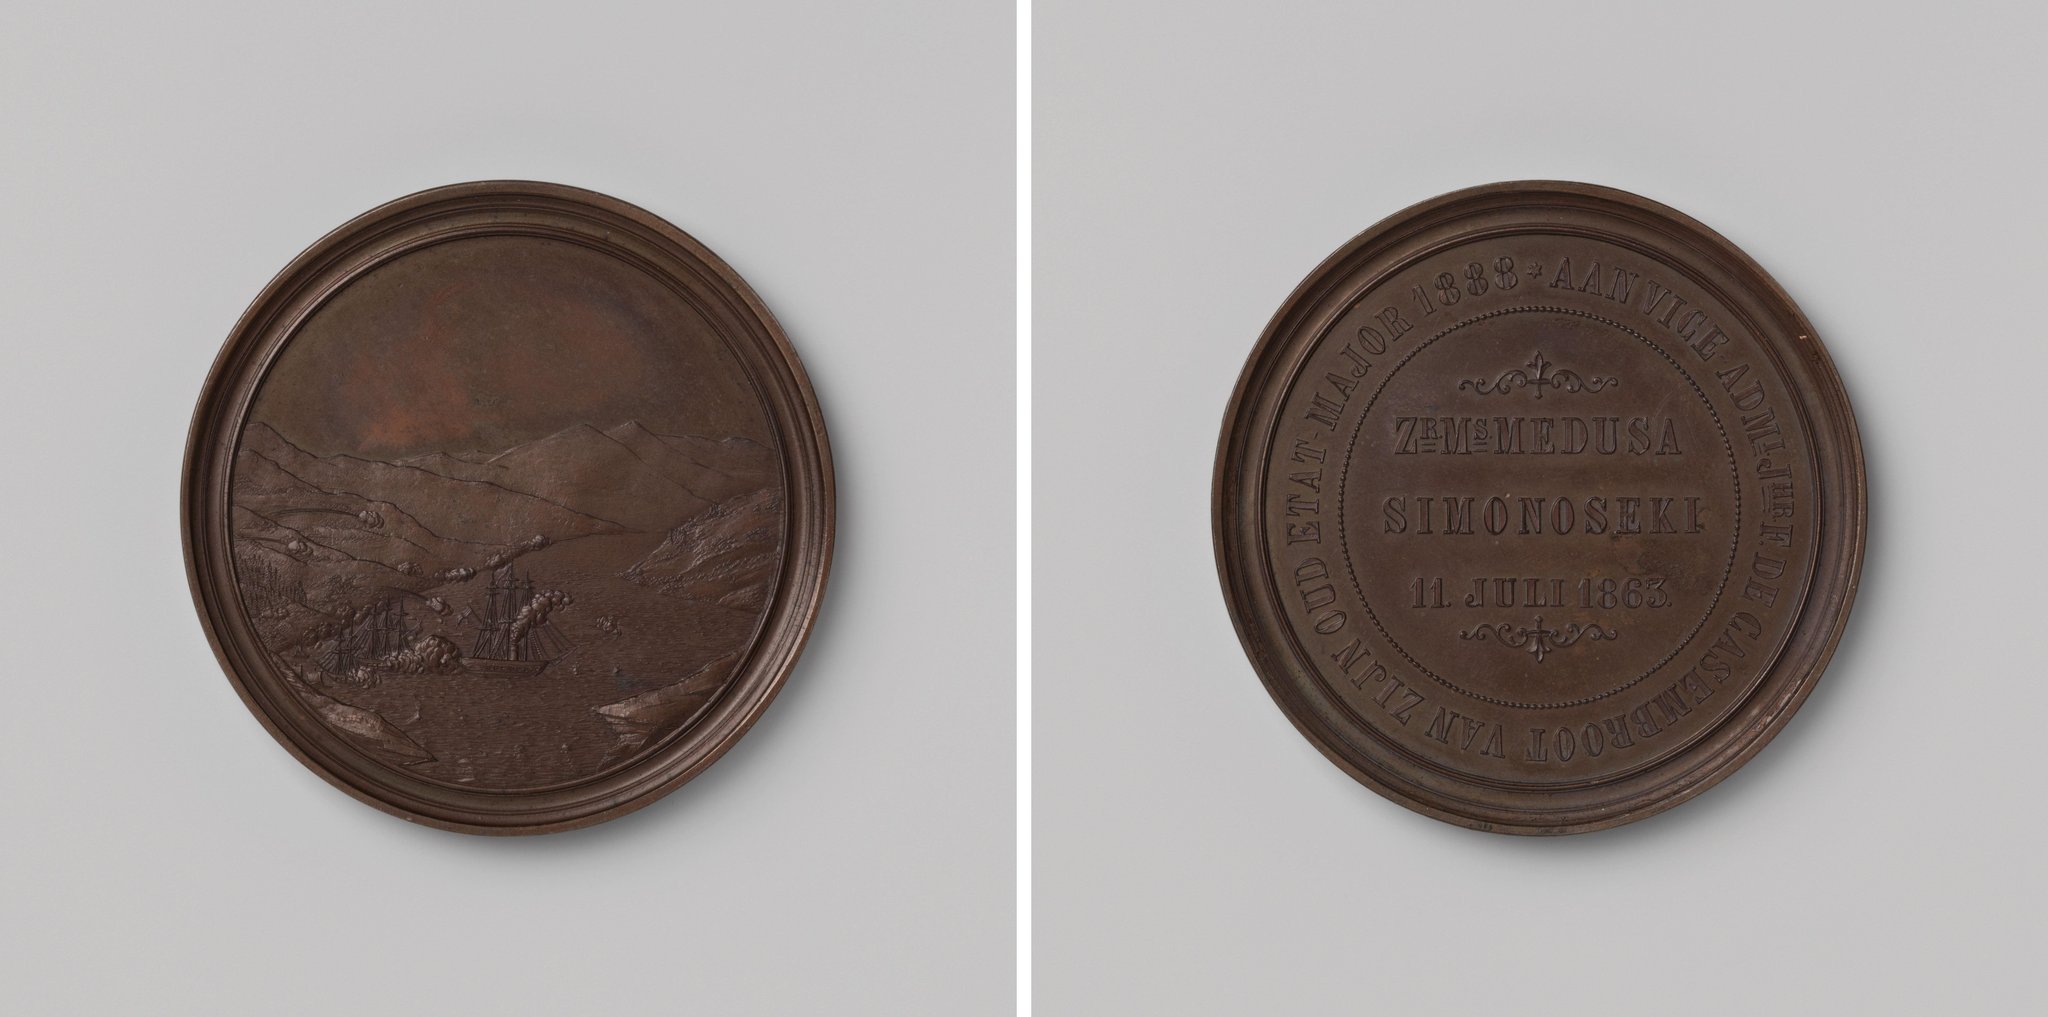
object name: honorary medal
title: Jhr. Francois Frederik de Casembroot, wegens het forceren van de doorvaart in de Straat van Shimonoseki met het schip de Medusa, penning geschonken door zijn officieren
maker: Anonymous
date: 1888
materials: bronze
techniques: striking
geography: netherlands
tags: liège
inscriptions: date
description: Bronzen penning. Voorzijde: een baai omringd door heuvels met vurende schepen op de voorgrond. Keerzijde: Omschrift: AAN VICE-ADMi Jhr F. DE CASEMBROOT VAN ZIJN OUD ETAT-MAJOR 1888. In het midden opschrift: Zr Ms MEDUSA / SIMONOSEKI / 11 JULI 1863; boven en onder opschrift gestileerde guirlandes met 3-bladige kelk in het midden. Tusen de 2 opschriften dunne parelrand. Reliëfrand eromheen.